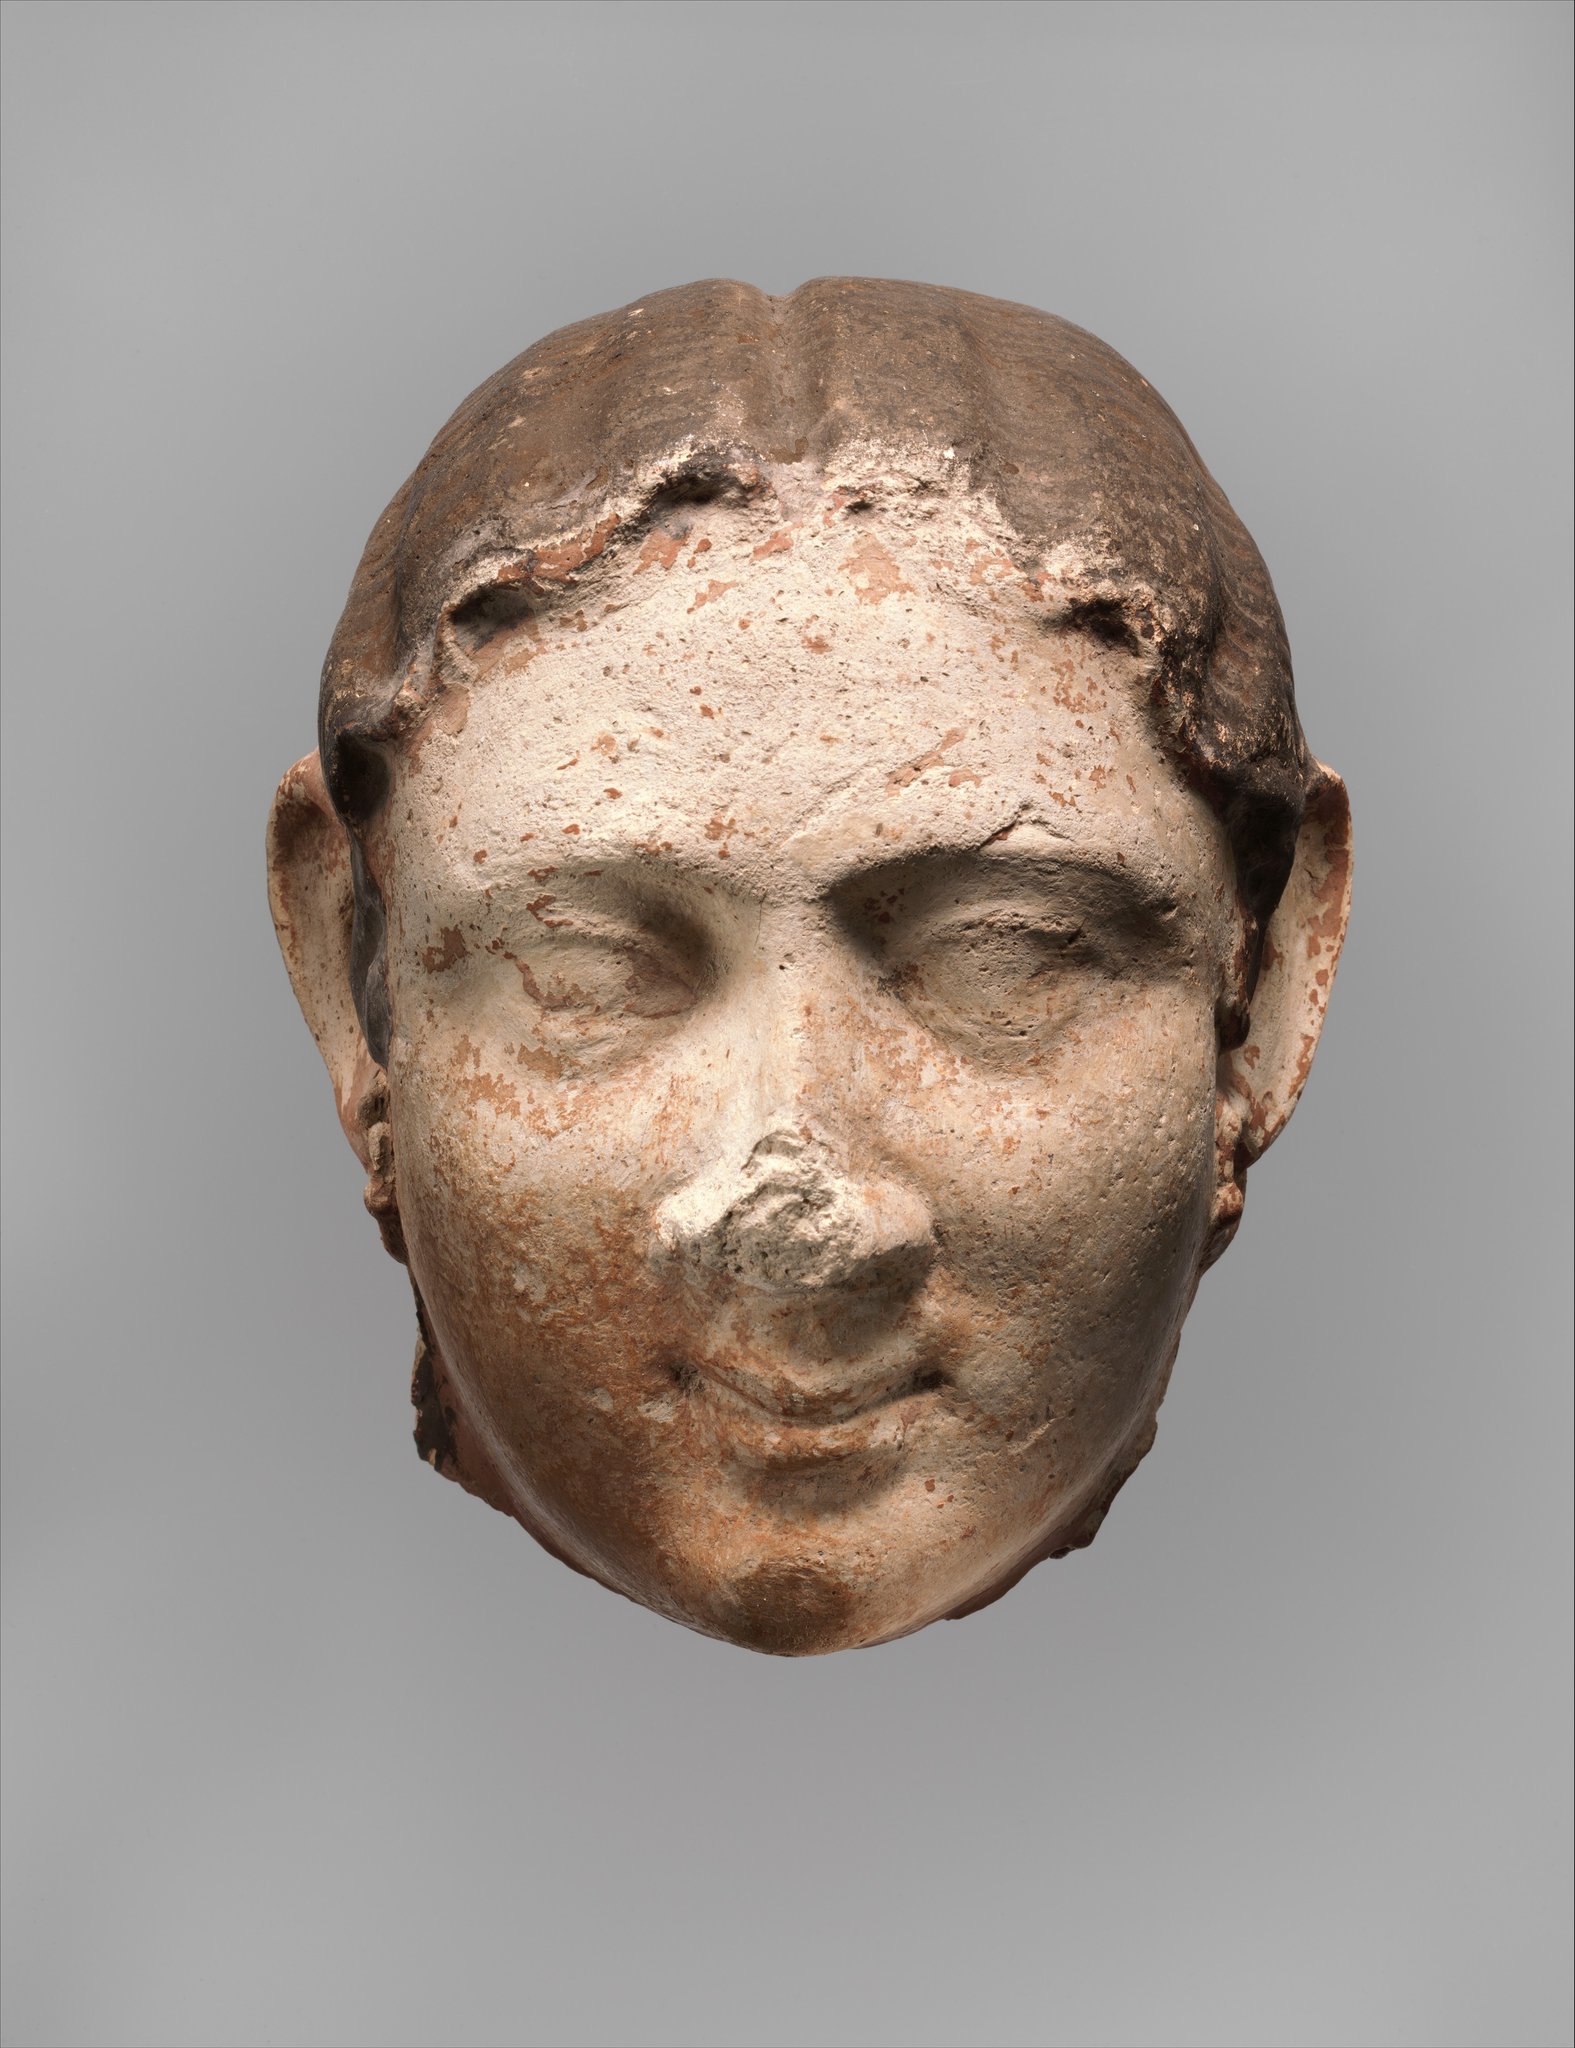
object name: mask of a woman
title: Funerary Mask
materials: paint, plaster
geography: egypt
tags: masks